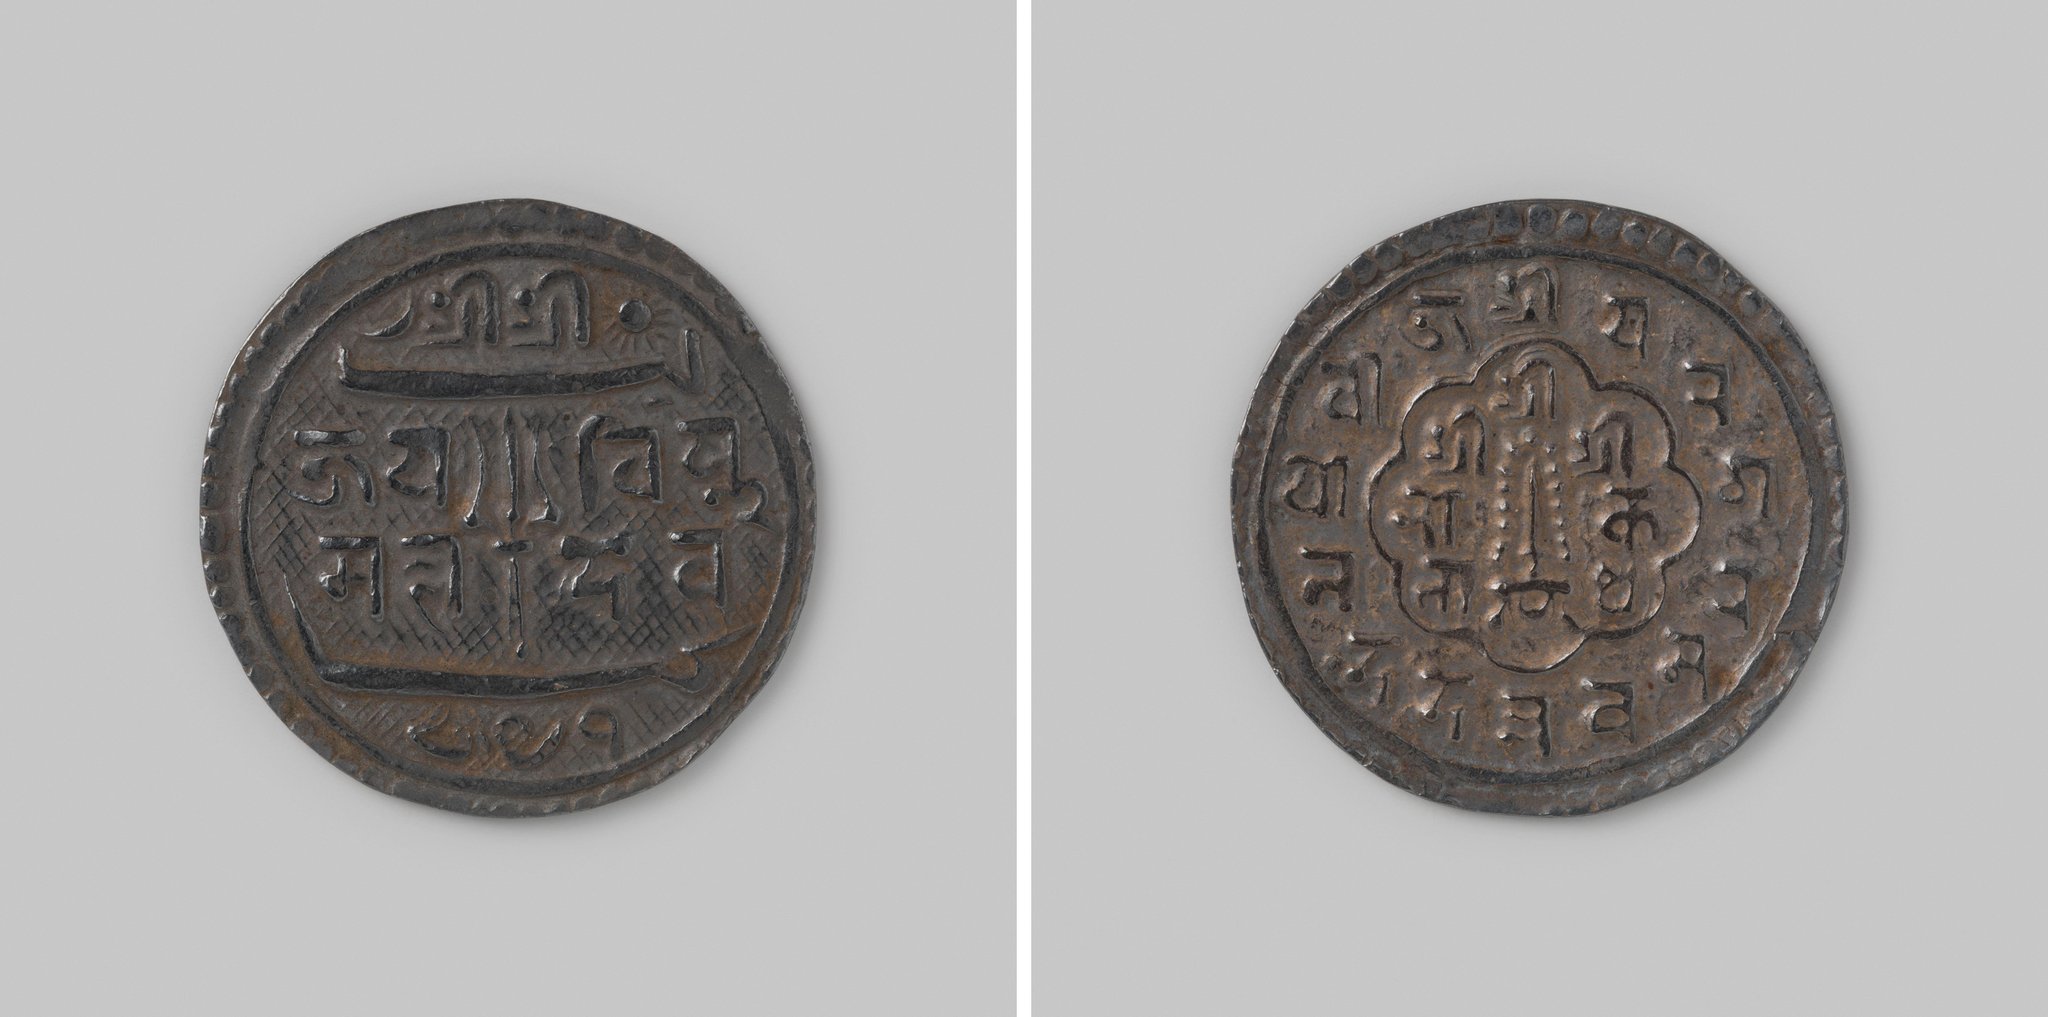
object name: coin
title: Mohar uit Nepal van Prithvi Narayana uit de Gurkha dynastie, 891 [= 1770]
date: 1770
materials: silver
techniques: striking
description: Zilveren munt. Voorzijde: binnen een vierkant in een cirkel een drietand, waaromheen twaalf tekens in Nagari-schrift met de betekenis: sri sri Prithvi Narayana saha deva. Rondom het vierkant een soort van veelpas met ornamenten. In onderste twee ornamenten jaartal in Nepalese cijfers: 891. Keerzijde: binnen een cirkel een stupa. Rondom de cirkel een rand met ornamenten, waarin acht afgescheiden ruimtes, met in elke ruimte een teken in Nagari-schrift met de betekenis: sri sri sri gorakhanatha. Gladde rand.